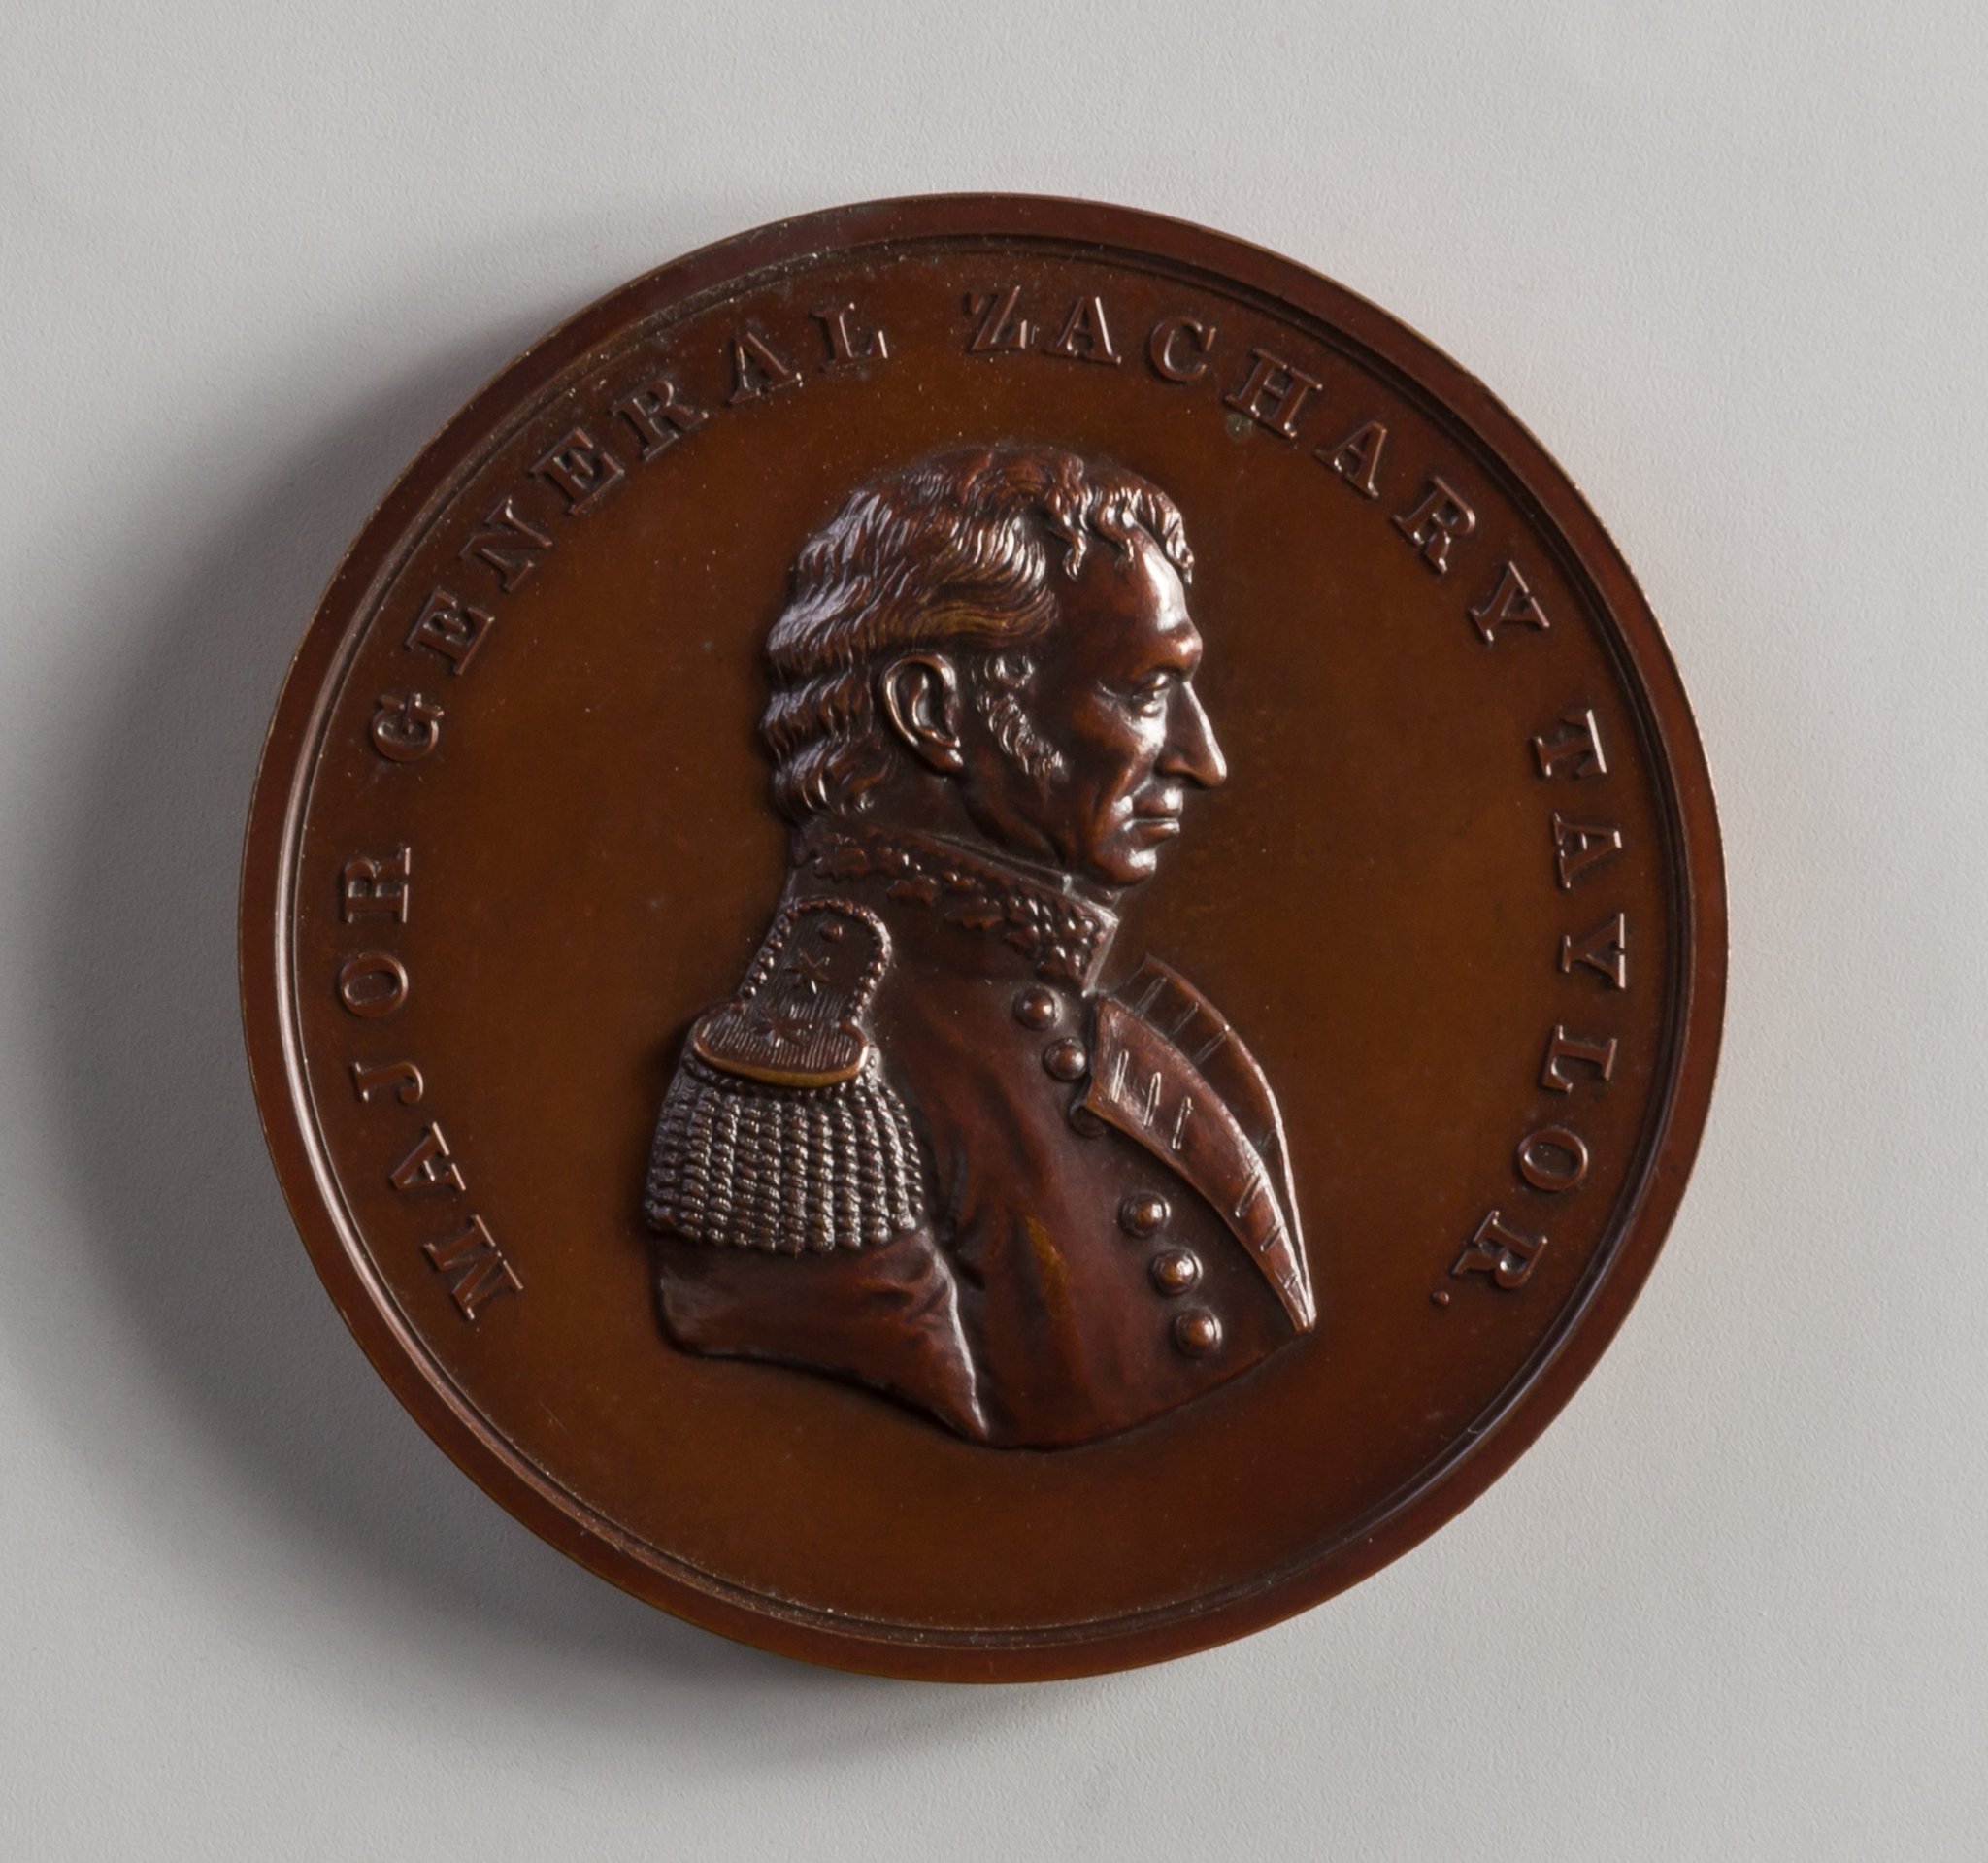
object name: medal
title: Medal of Major General Z. Taylor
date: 1846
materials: bronze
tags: men,profiles